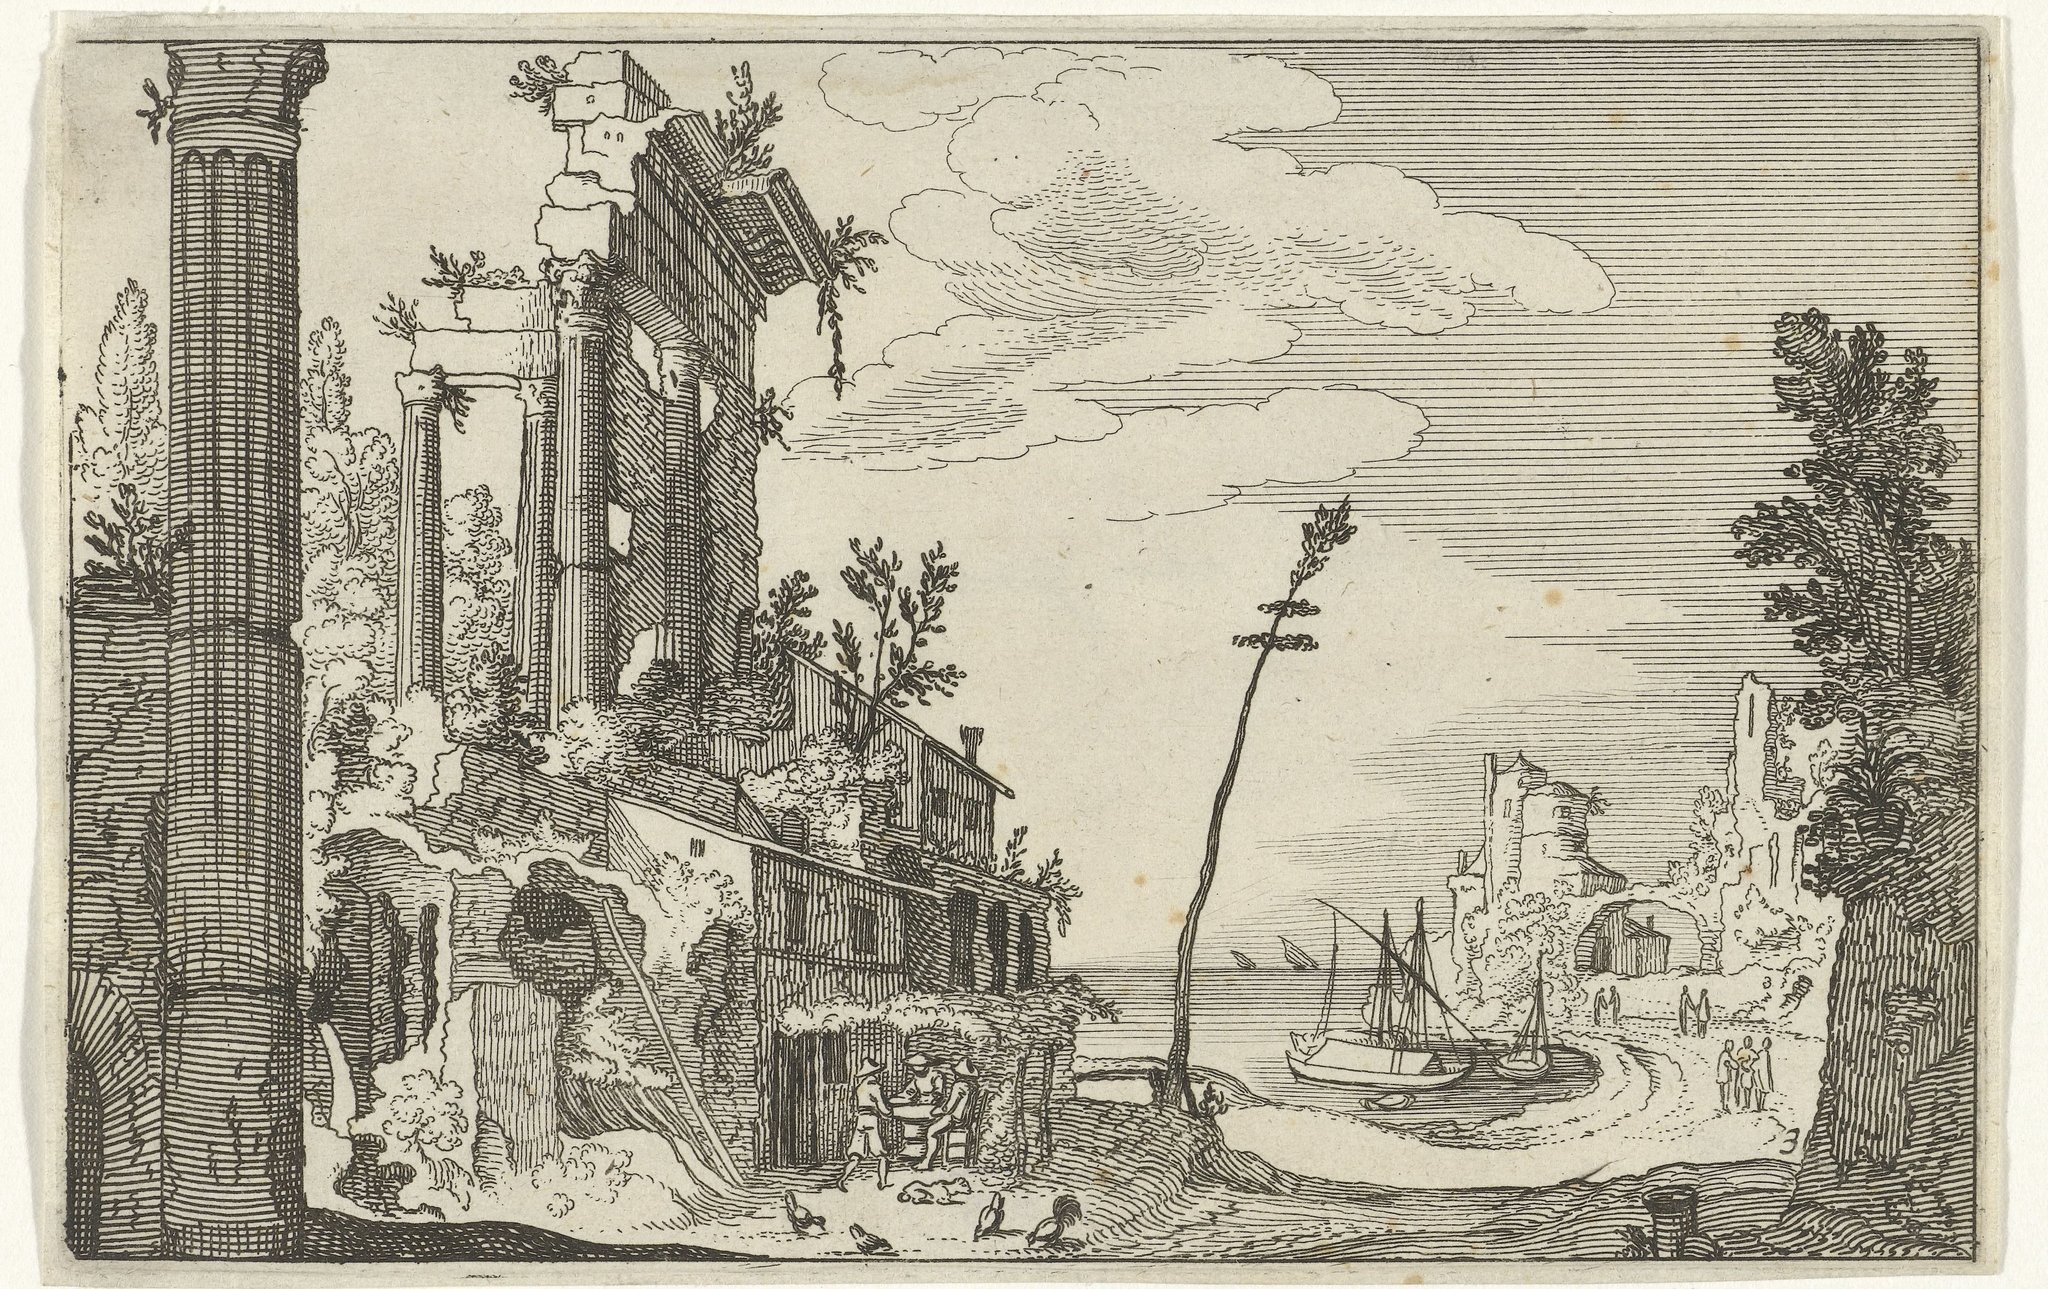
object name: print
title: Romeinse ruïnes en kustlandschappen (serie 1)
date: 1618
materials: paper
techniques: etching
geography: amsterdam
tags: ruin of a building ~ architecture, landscape with ruins, coast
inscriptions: collector's mark: Lugt 2228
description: Links een zuil en een onder een ruïne van een Romeinse tempel gebouwd huis. Daarachter het strand met een fort en een boogvormige onderdoorgang in de rotsen. Twee bootjes liggen aan de kust. Prent maakt deel uit van een serie Romeinse ruïnes en kustlandschappen naar een prentserie van Willem van Nieulandt.